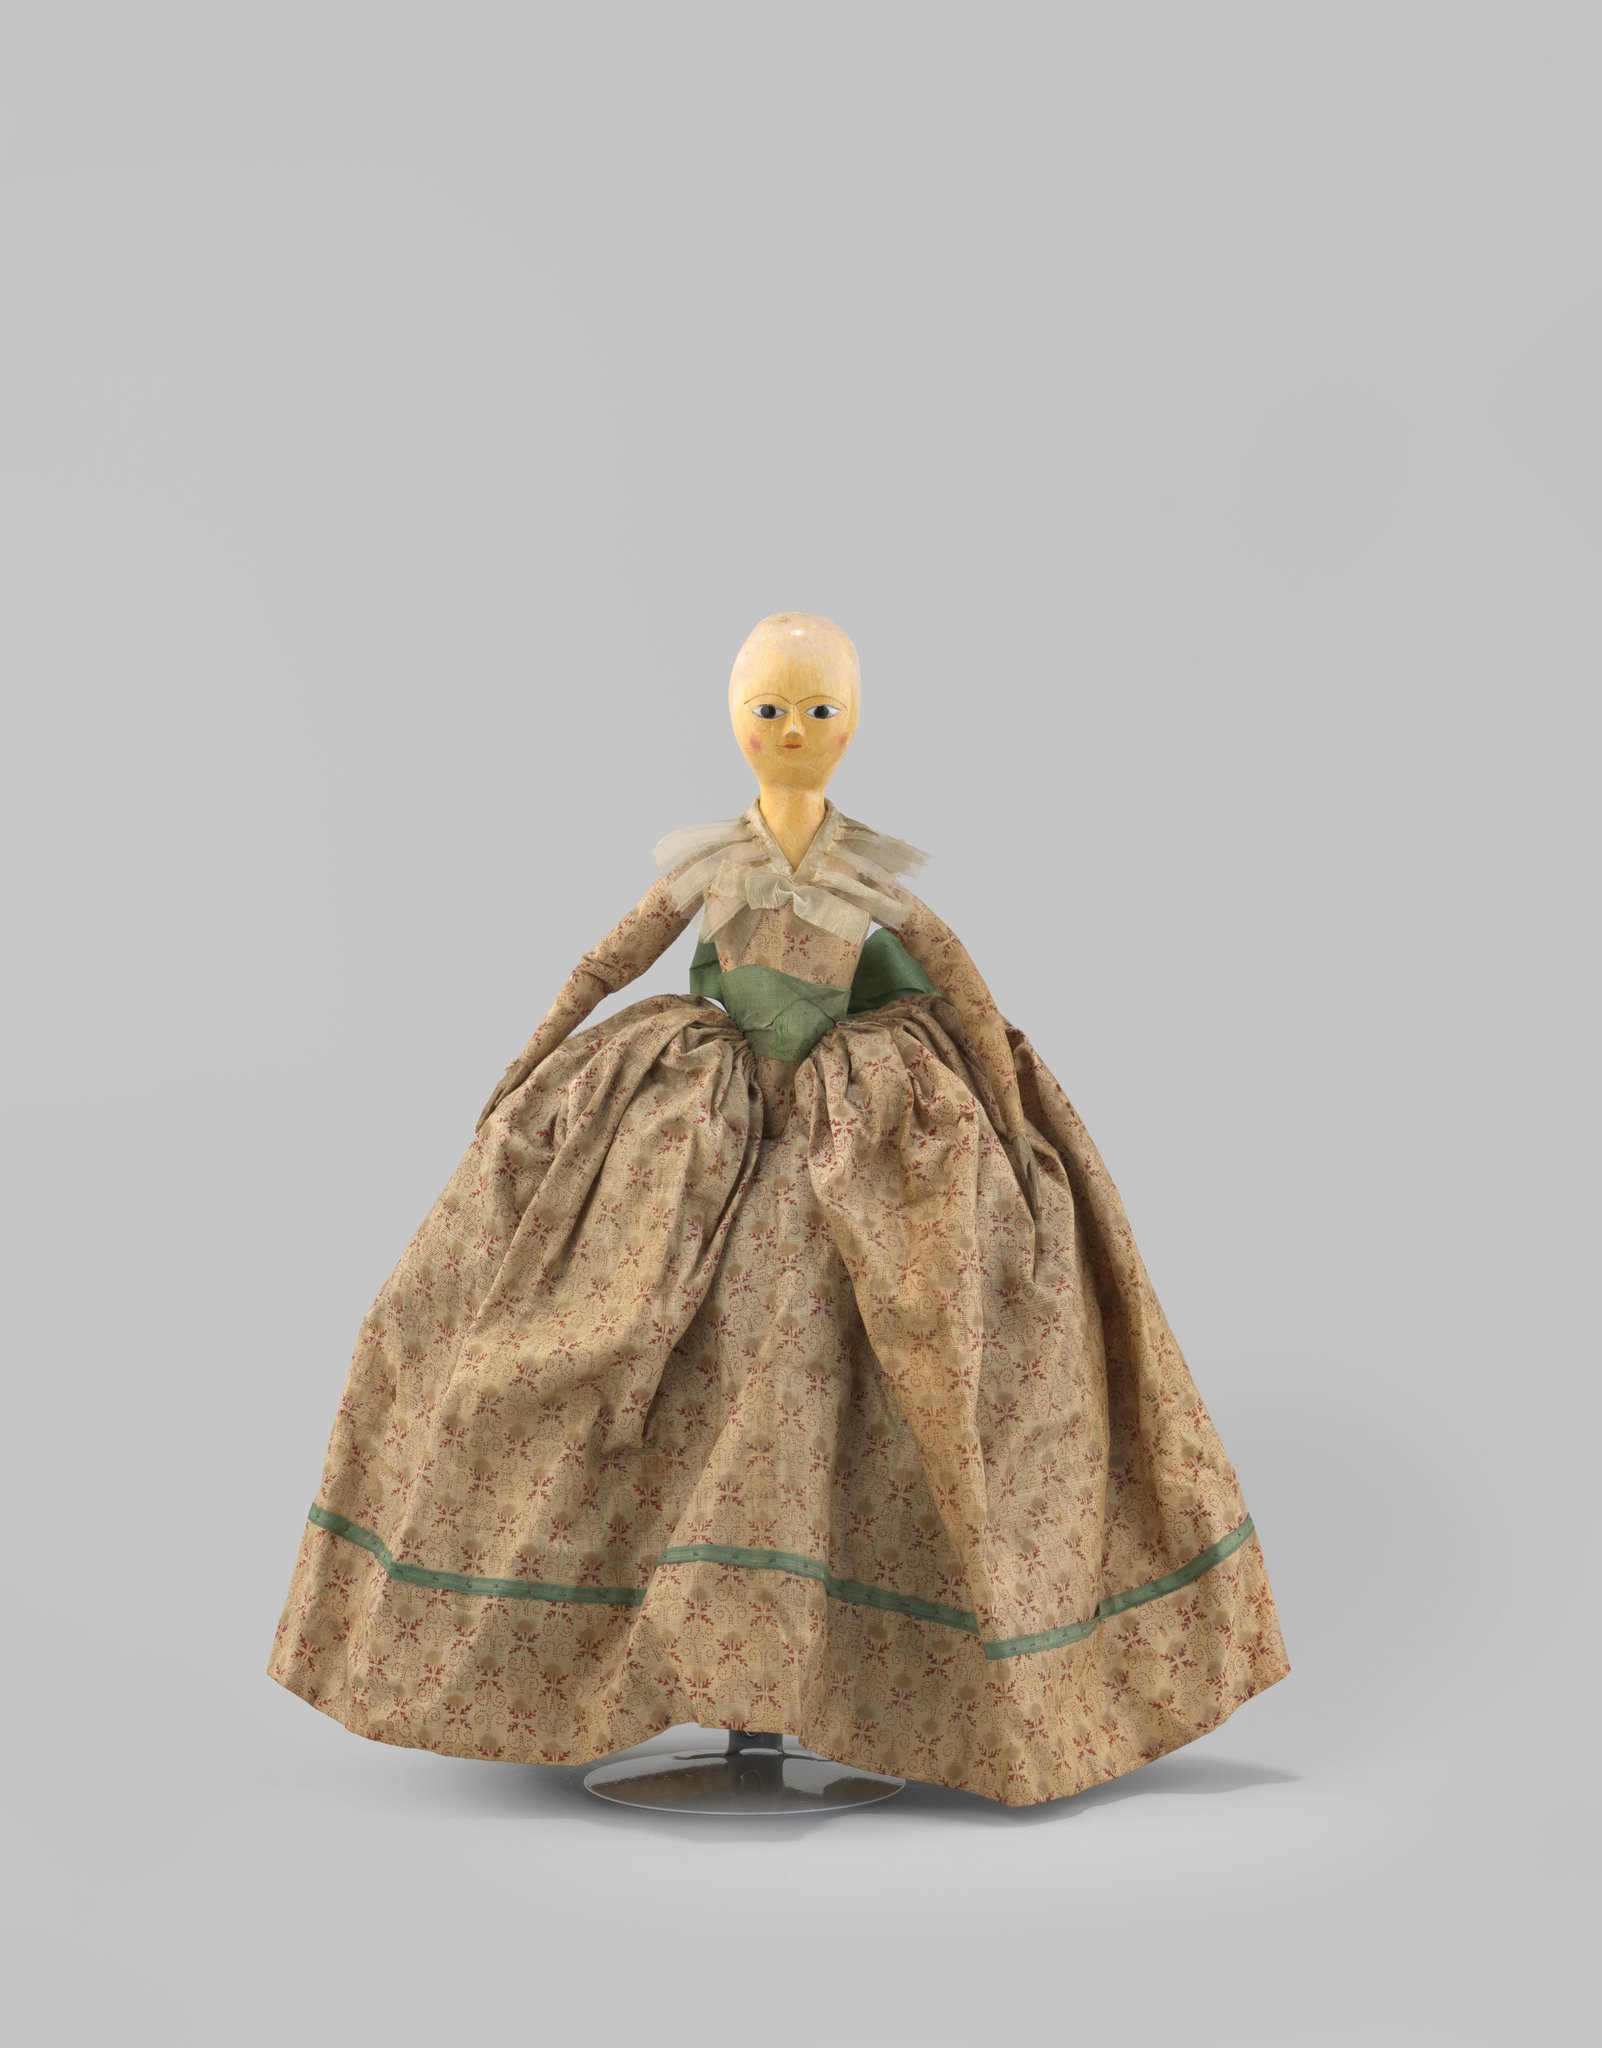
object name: doll's clothing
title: Pop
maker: Anonymous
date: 1800-1900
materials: wood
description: Pop met jurk en met drie hoeden, vier mutsen en met enkele gemaakte bloemen.